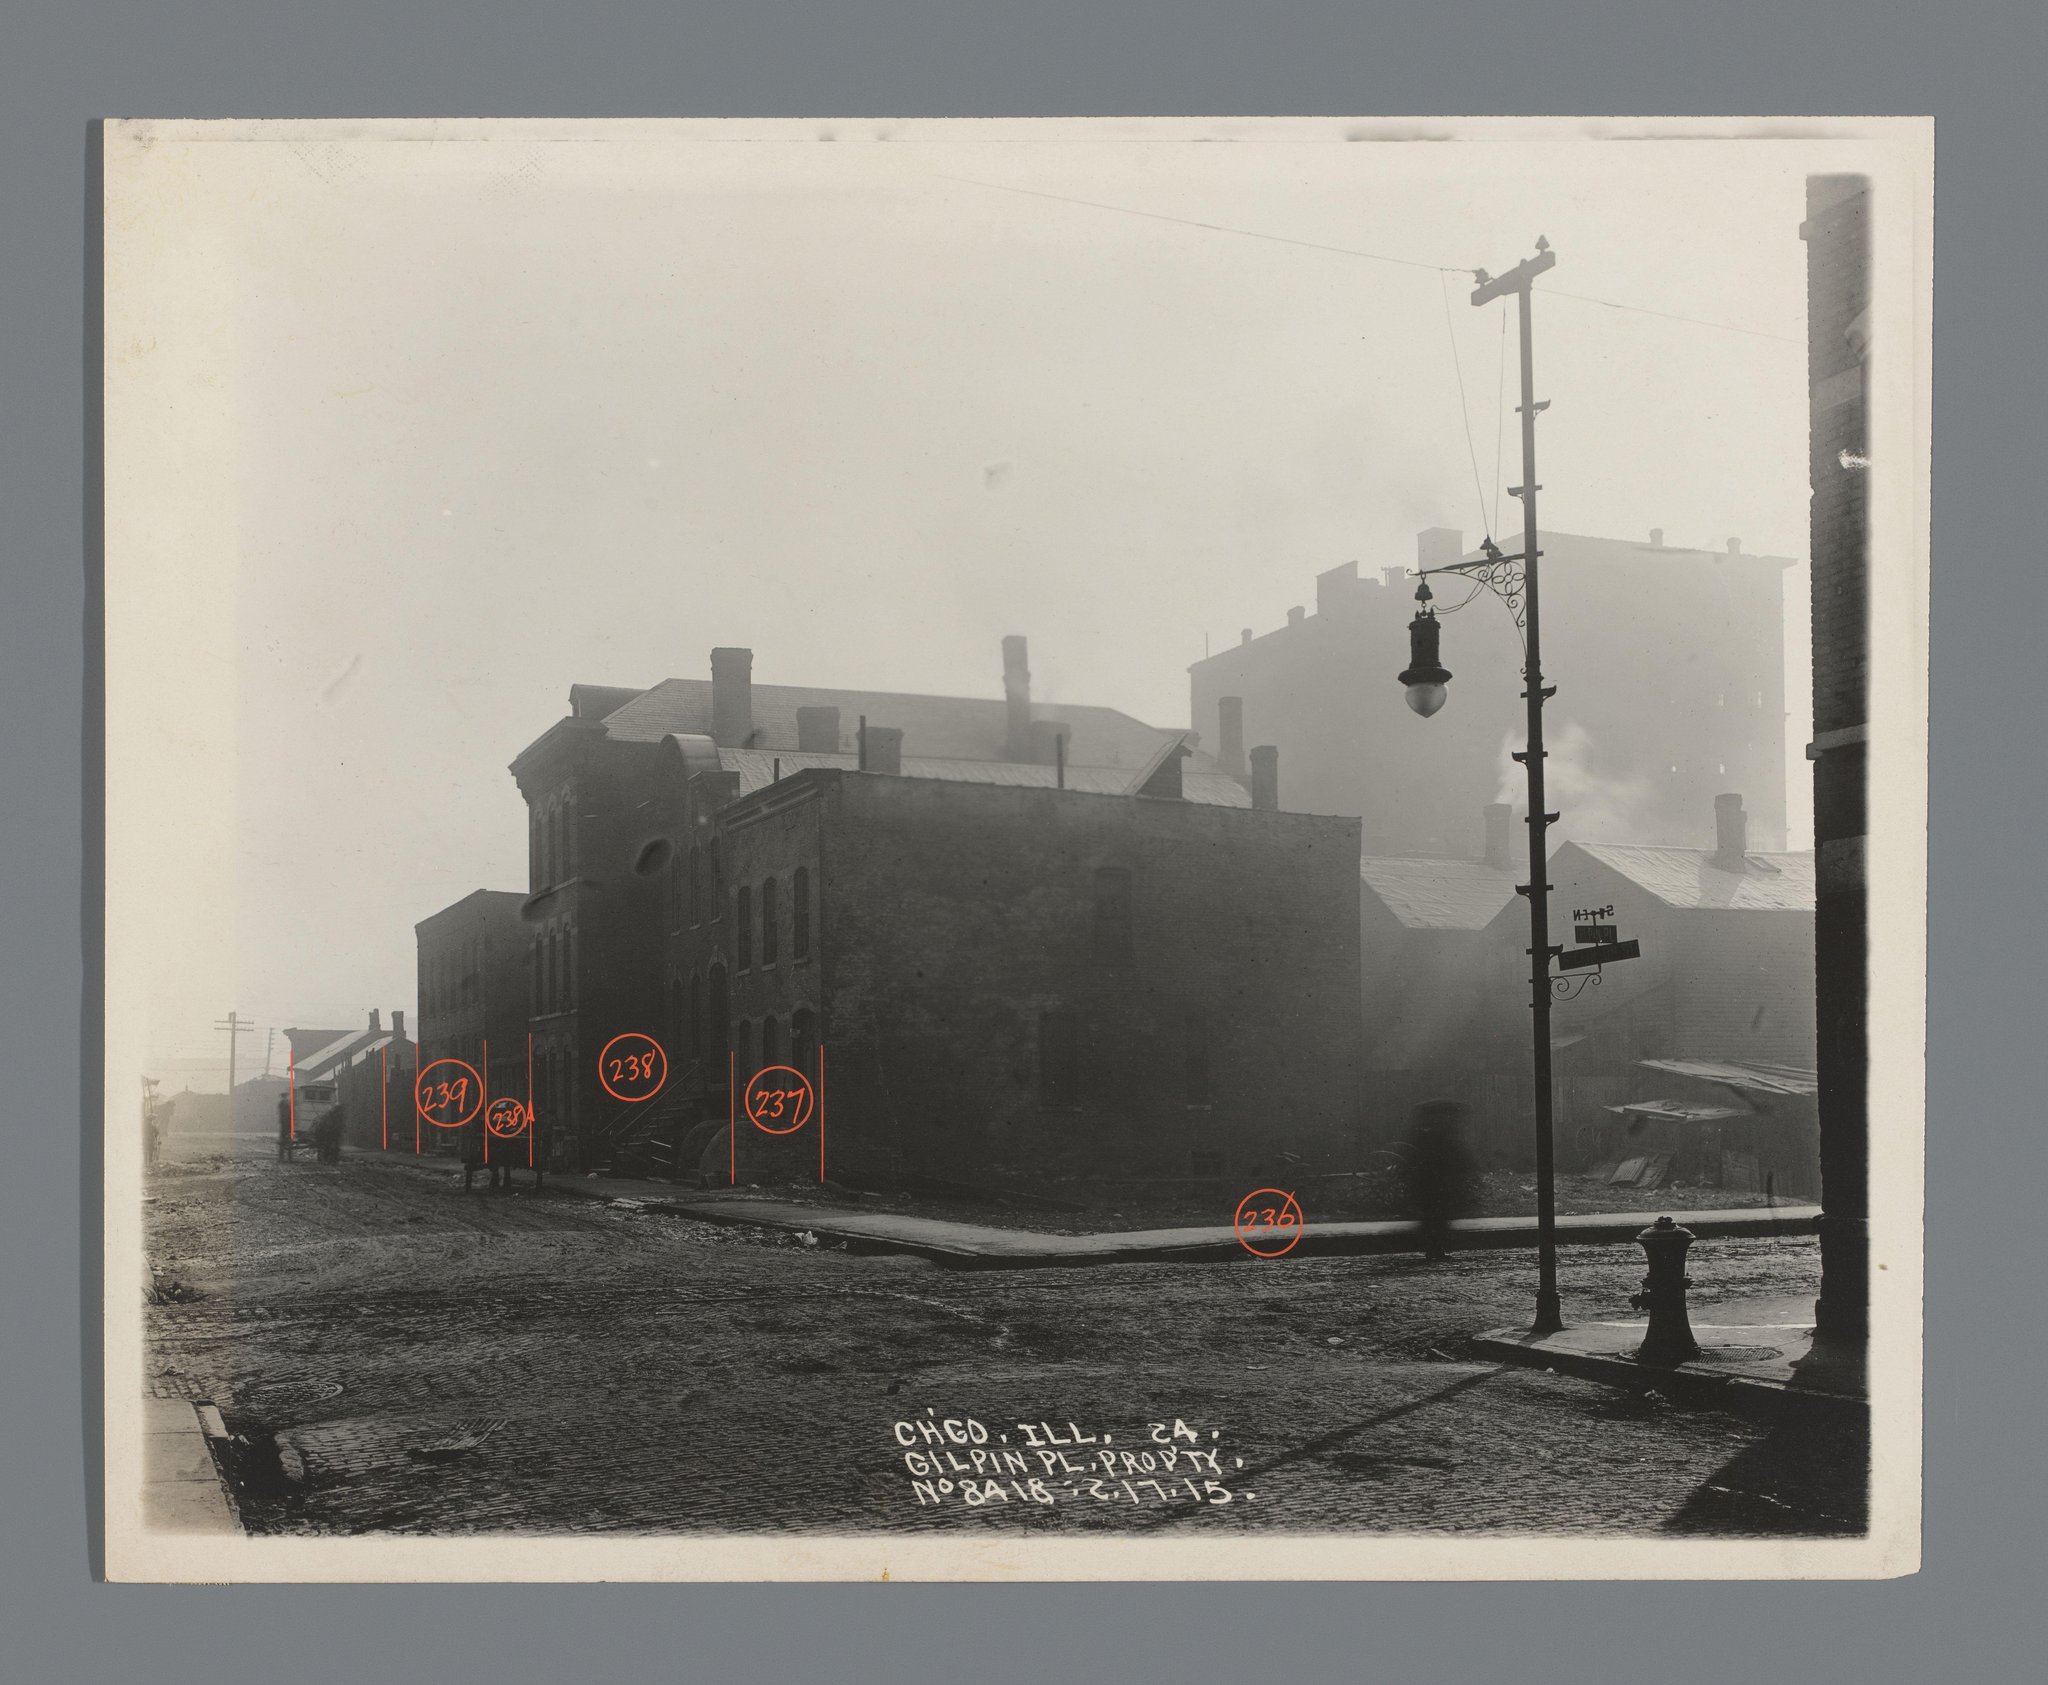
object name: photograph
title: Zicht op een straat in Chicago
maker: Anonymous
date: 1915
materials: ink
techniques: gelatin silver print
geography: united states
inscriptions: annotation: ‘CHGO. ILL. zA. / GILPIN PL. PROPTY. / No 8418 2.17.15.’, annotation: ‘South Clinton Street / intersection / Gilpin Place / Chicago, Illinois / Wednesday / February 17, 1915’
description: Met handgeschreven perceelnummers op de gebouwen in rode inkt. Mogelijk ten behoeve van de aanleg van een metro en/of een spoor.